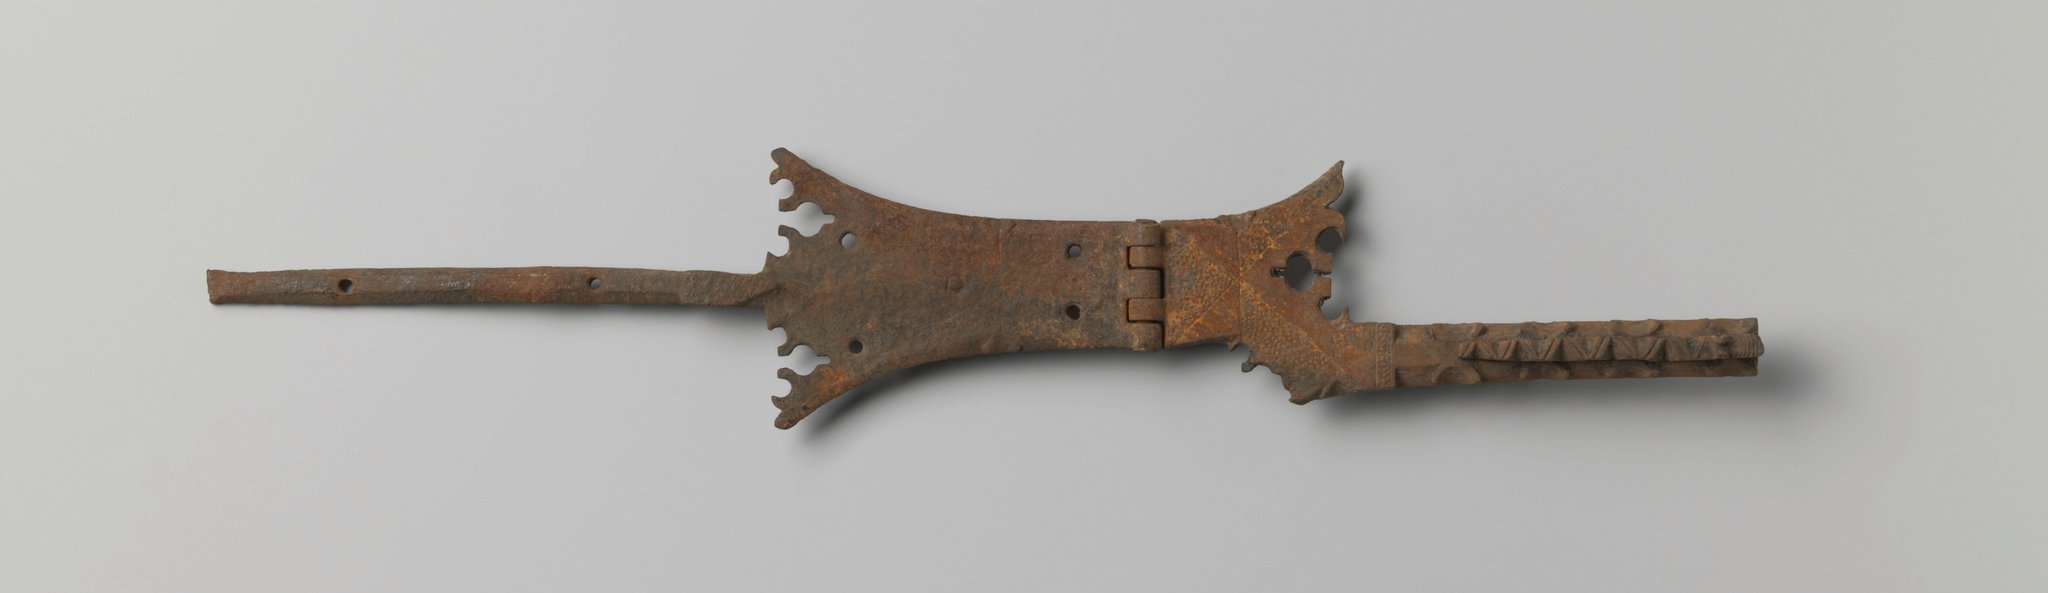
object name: overval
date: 1400-1950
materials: iron